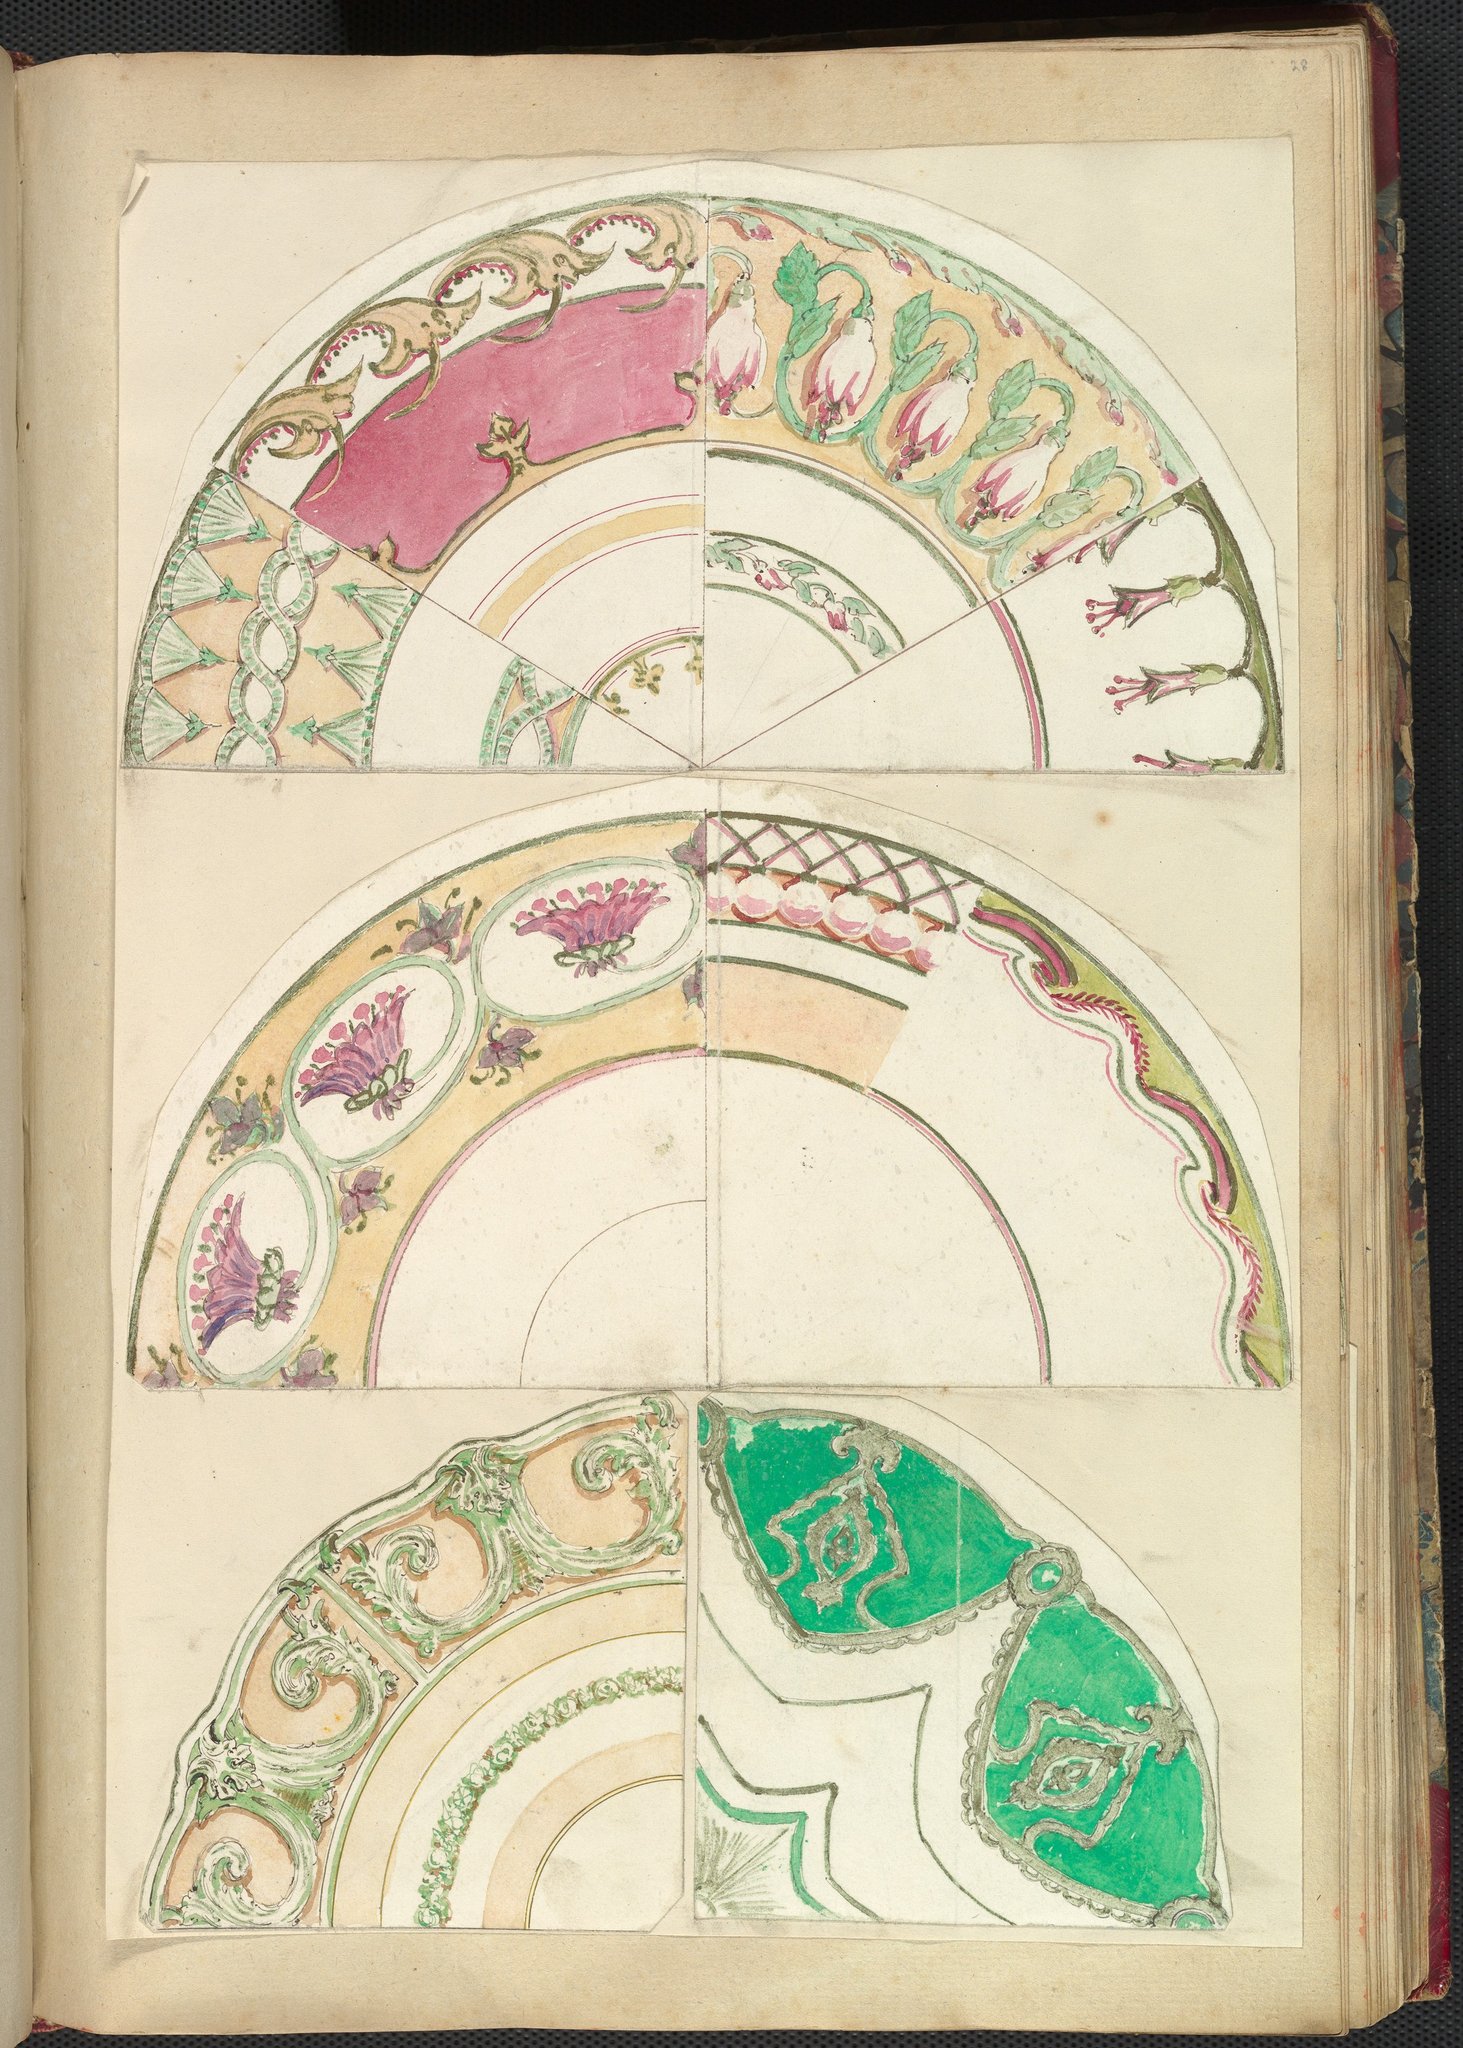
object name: drawing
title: Nine Designs for Decorated Plates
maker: alfred henry forrester [alfred crowquill]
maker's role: artist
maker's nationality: british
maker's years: 1804-1872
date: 1845-1855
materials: ink, watercolor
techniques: pen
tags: flowers